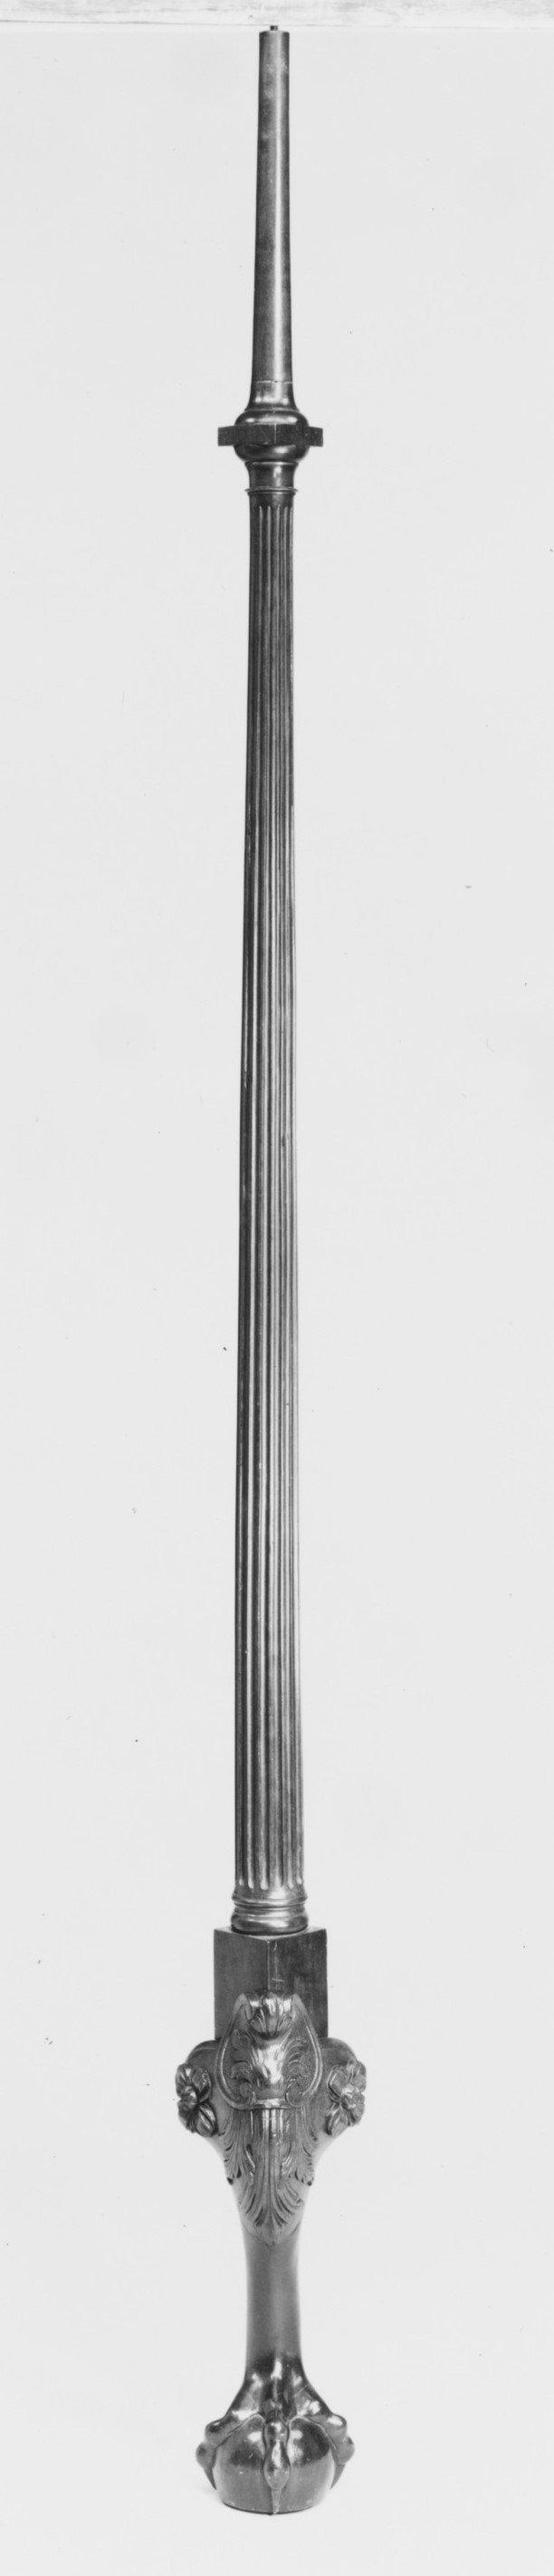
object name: bedstead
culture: american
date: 1760-1790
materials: wood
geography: united states